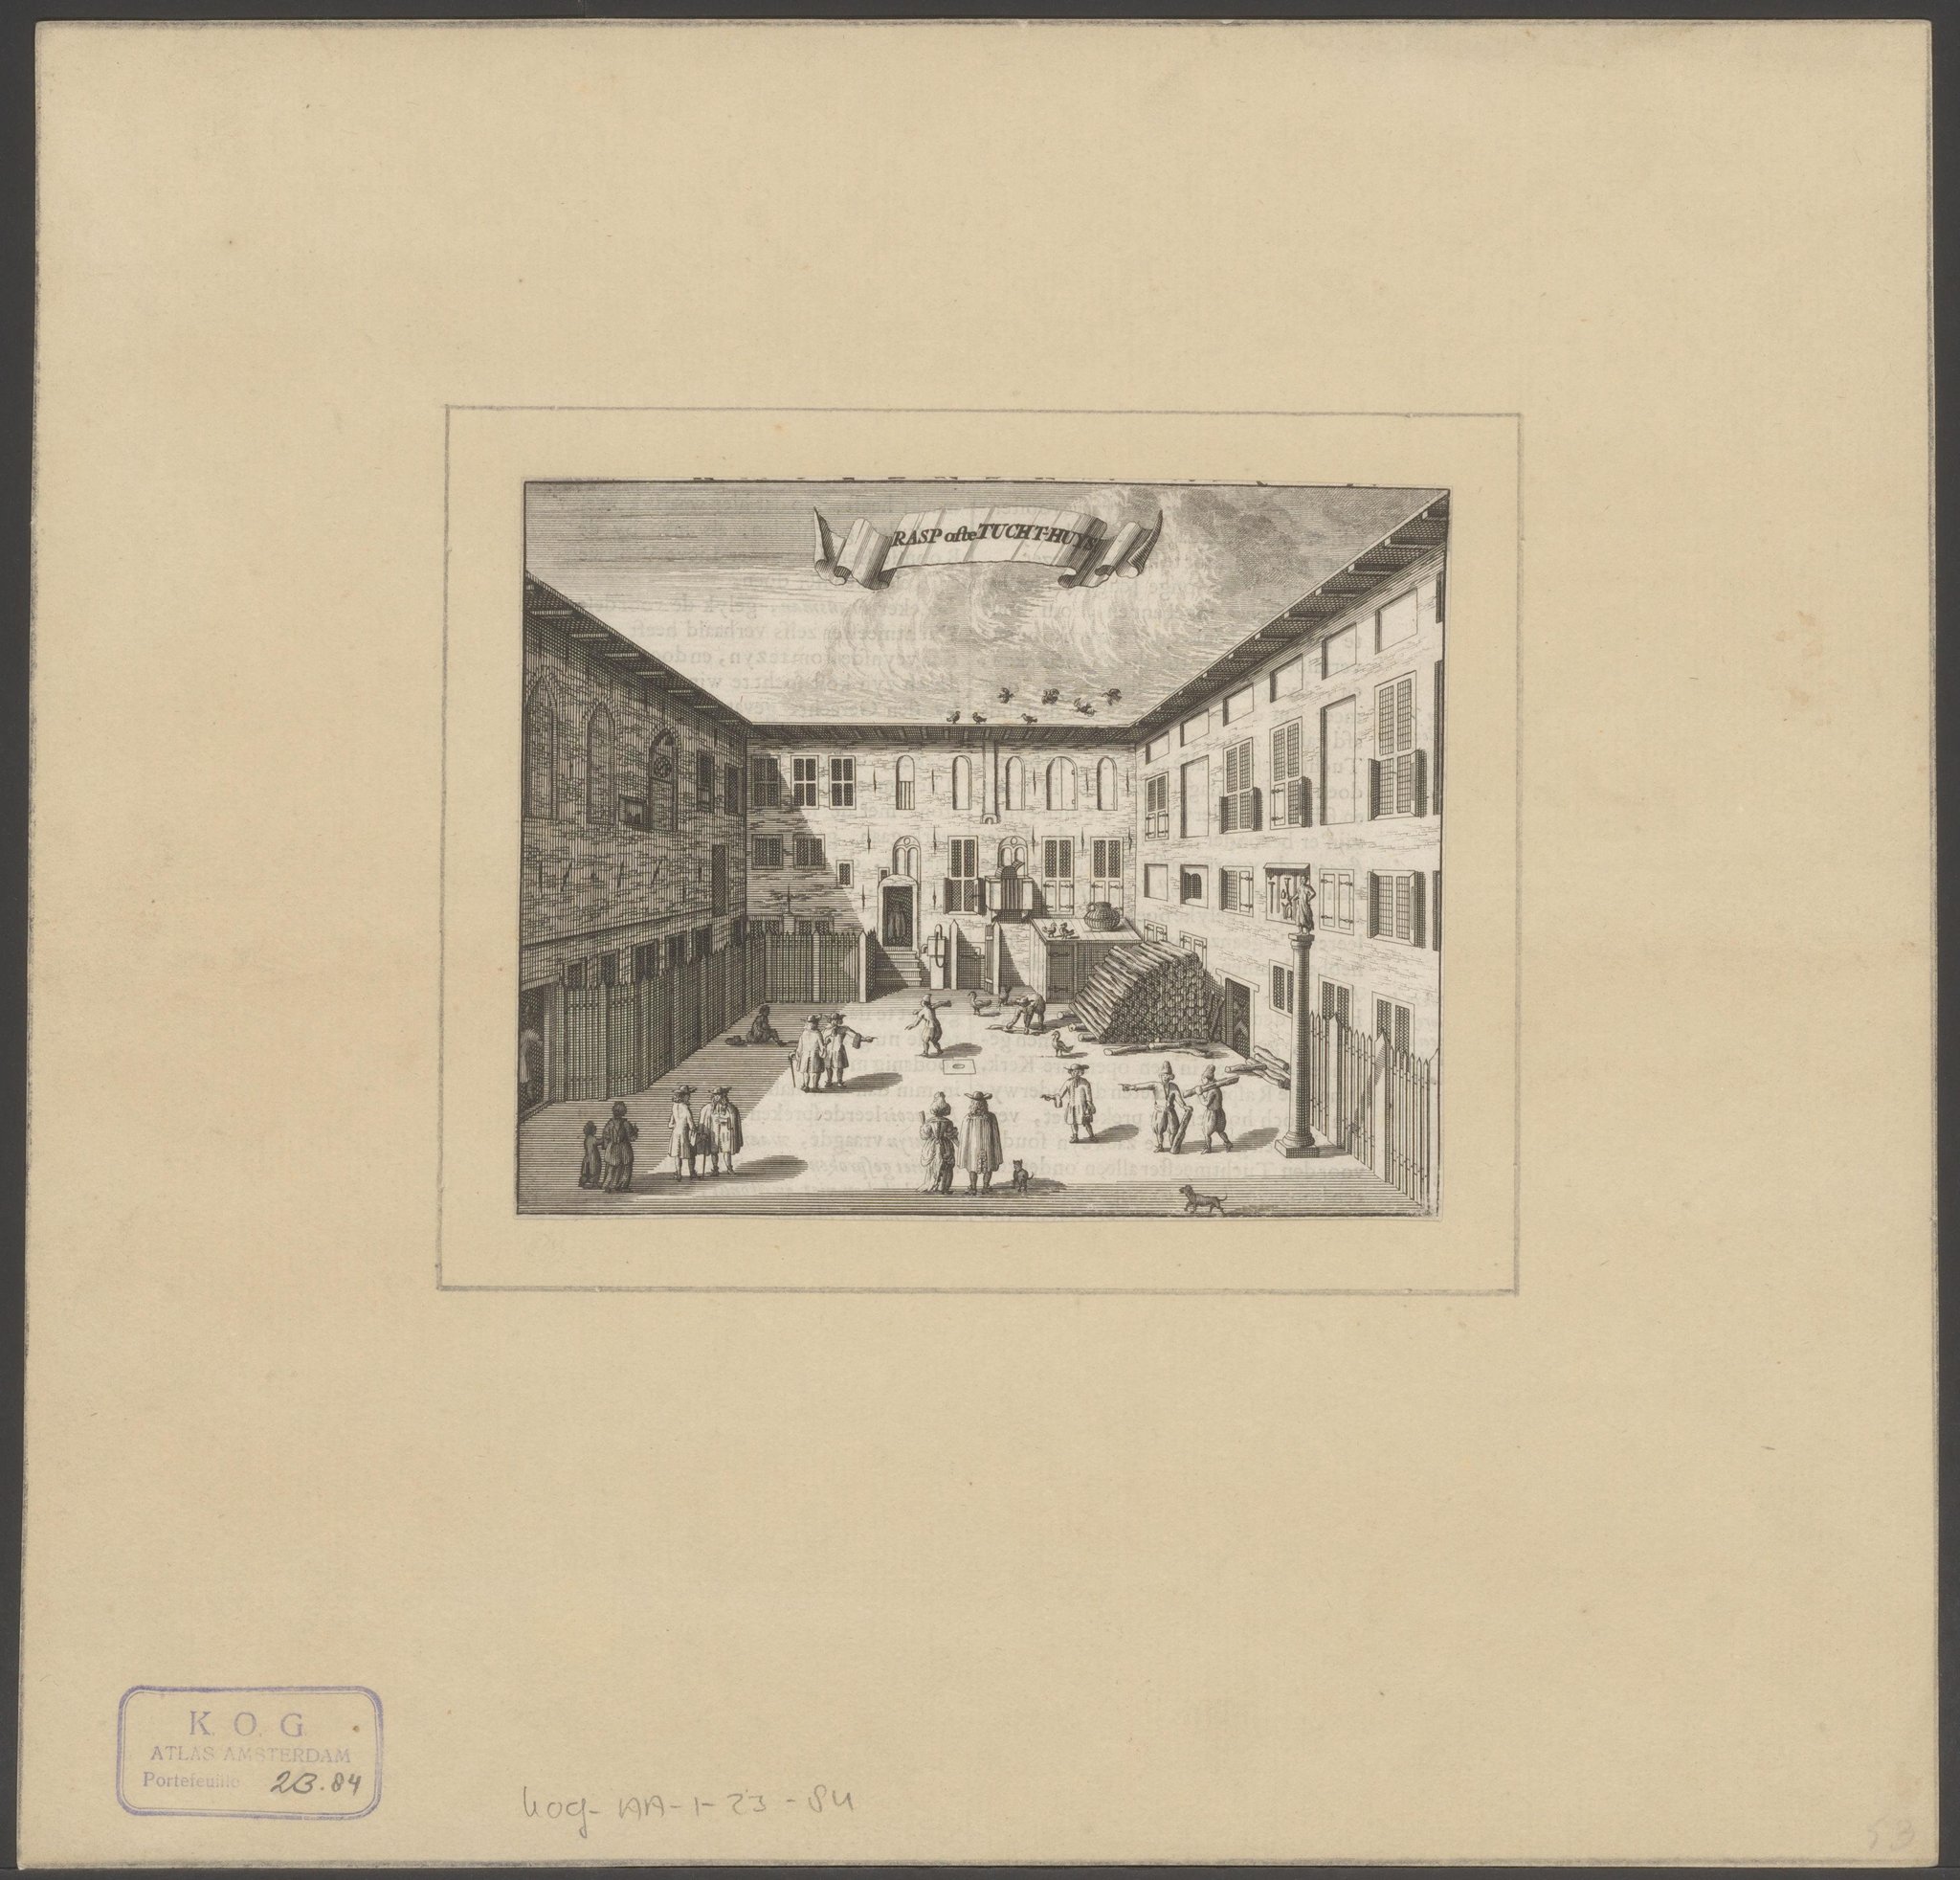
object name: book illustration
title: Gezicht op de binnenplaats van het Rasphuis te Amsterdam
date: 1693-1694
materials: paper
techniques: etching, letterpress printing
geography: northern netherlands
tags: prison, jail, (prisoners) in the prison yard, justitia (justice) as roman personification, workhouse, penal camp, penitentiary, chain gang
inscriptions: collector's mark: Lugt 1641b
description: Prent uit: Commelin, Casparus. Beschryvinge van Amsterdam (…). Amsterdam: Abraham Wolfgang, Gillis Janssonius van Waesberge of Johannes Janssonius van Waesberge, Hendrick Boom of weduwe Dirk Boom, Abraham van Sanderen en Rembertus Goethals, 1693, dl. 1, p. 509. Of uit: Commelin, Casparus. Beschryvinge van Amsterdam (…). Amsterdam: weduwe Aart Dircksz. Oossaan, 1694, dl. 1, p. 509.